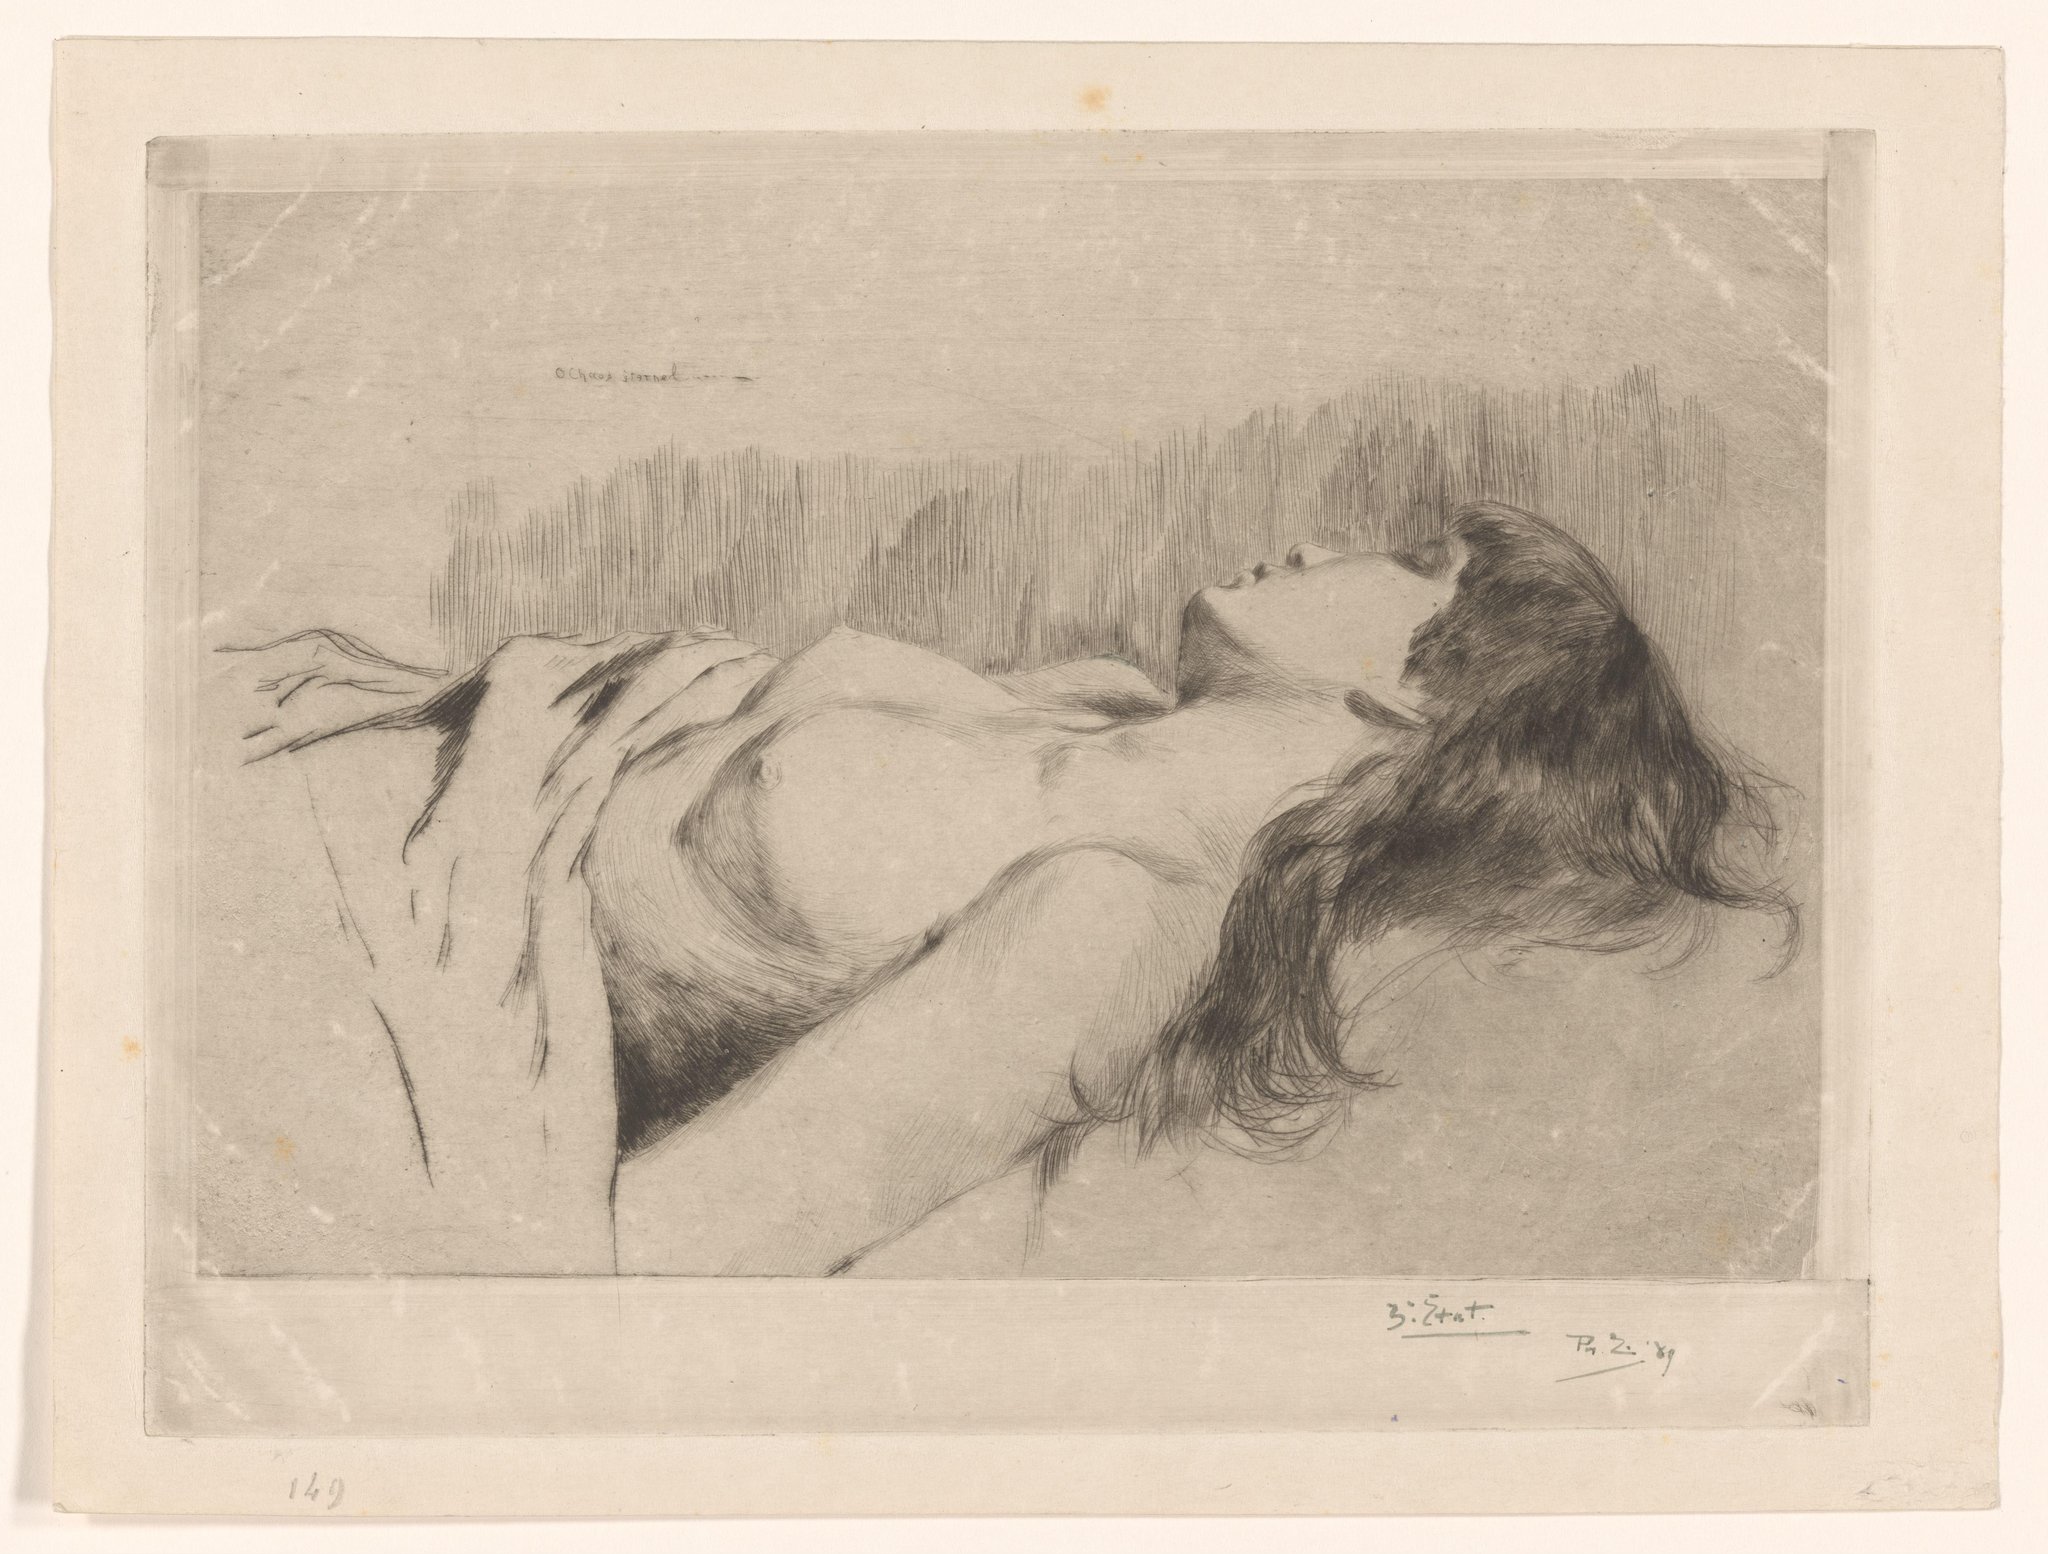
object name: print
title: O chaos éternel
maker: philip zilcken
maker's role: draughtsman, painter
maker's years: 1857-1930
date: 1889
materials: paper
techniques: drypoint, intaglio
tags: sleeping in bed, the (nude) human figure; 'corpo humano' (ripa) - aa - female human figure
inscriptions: collector's mark: Lugt 2233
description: Slapende vrouw met ontbloot bovenlichaam.